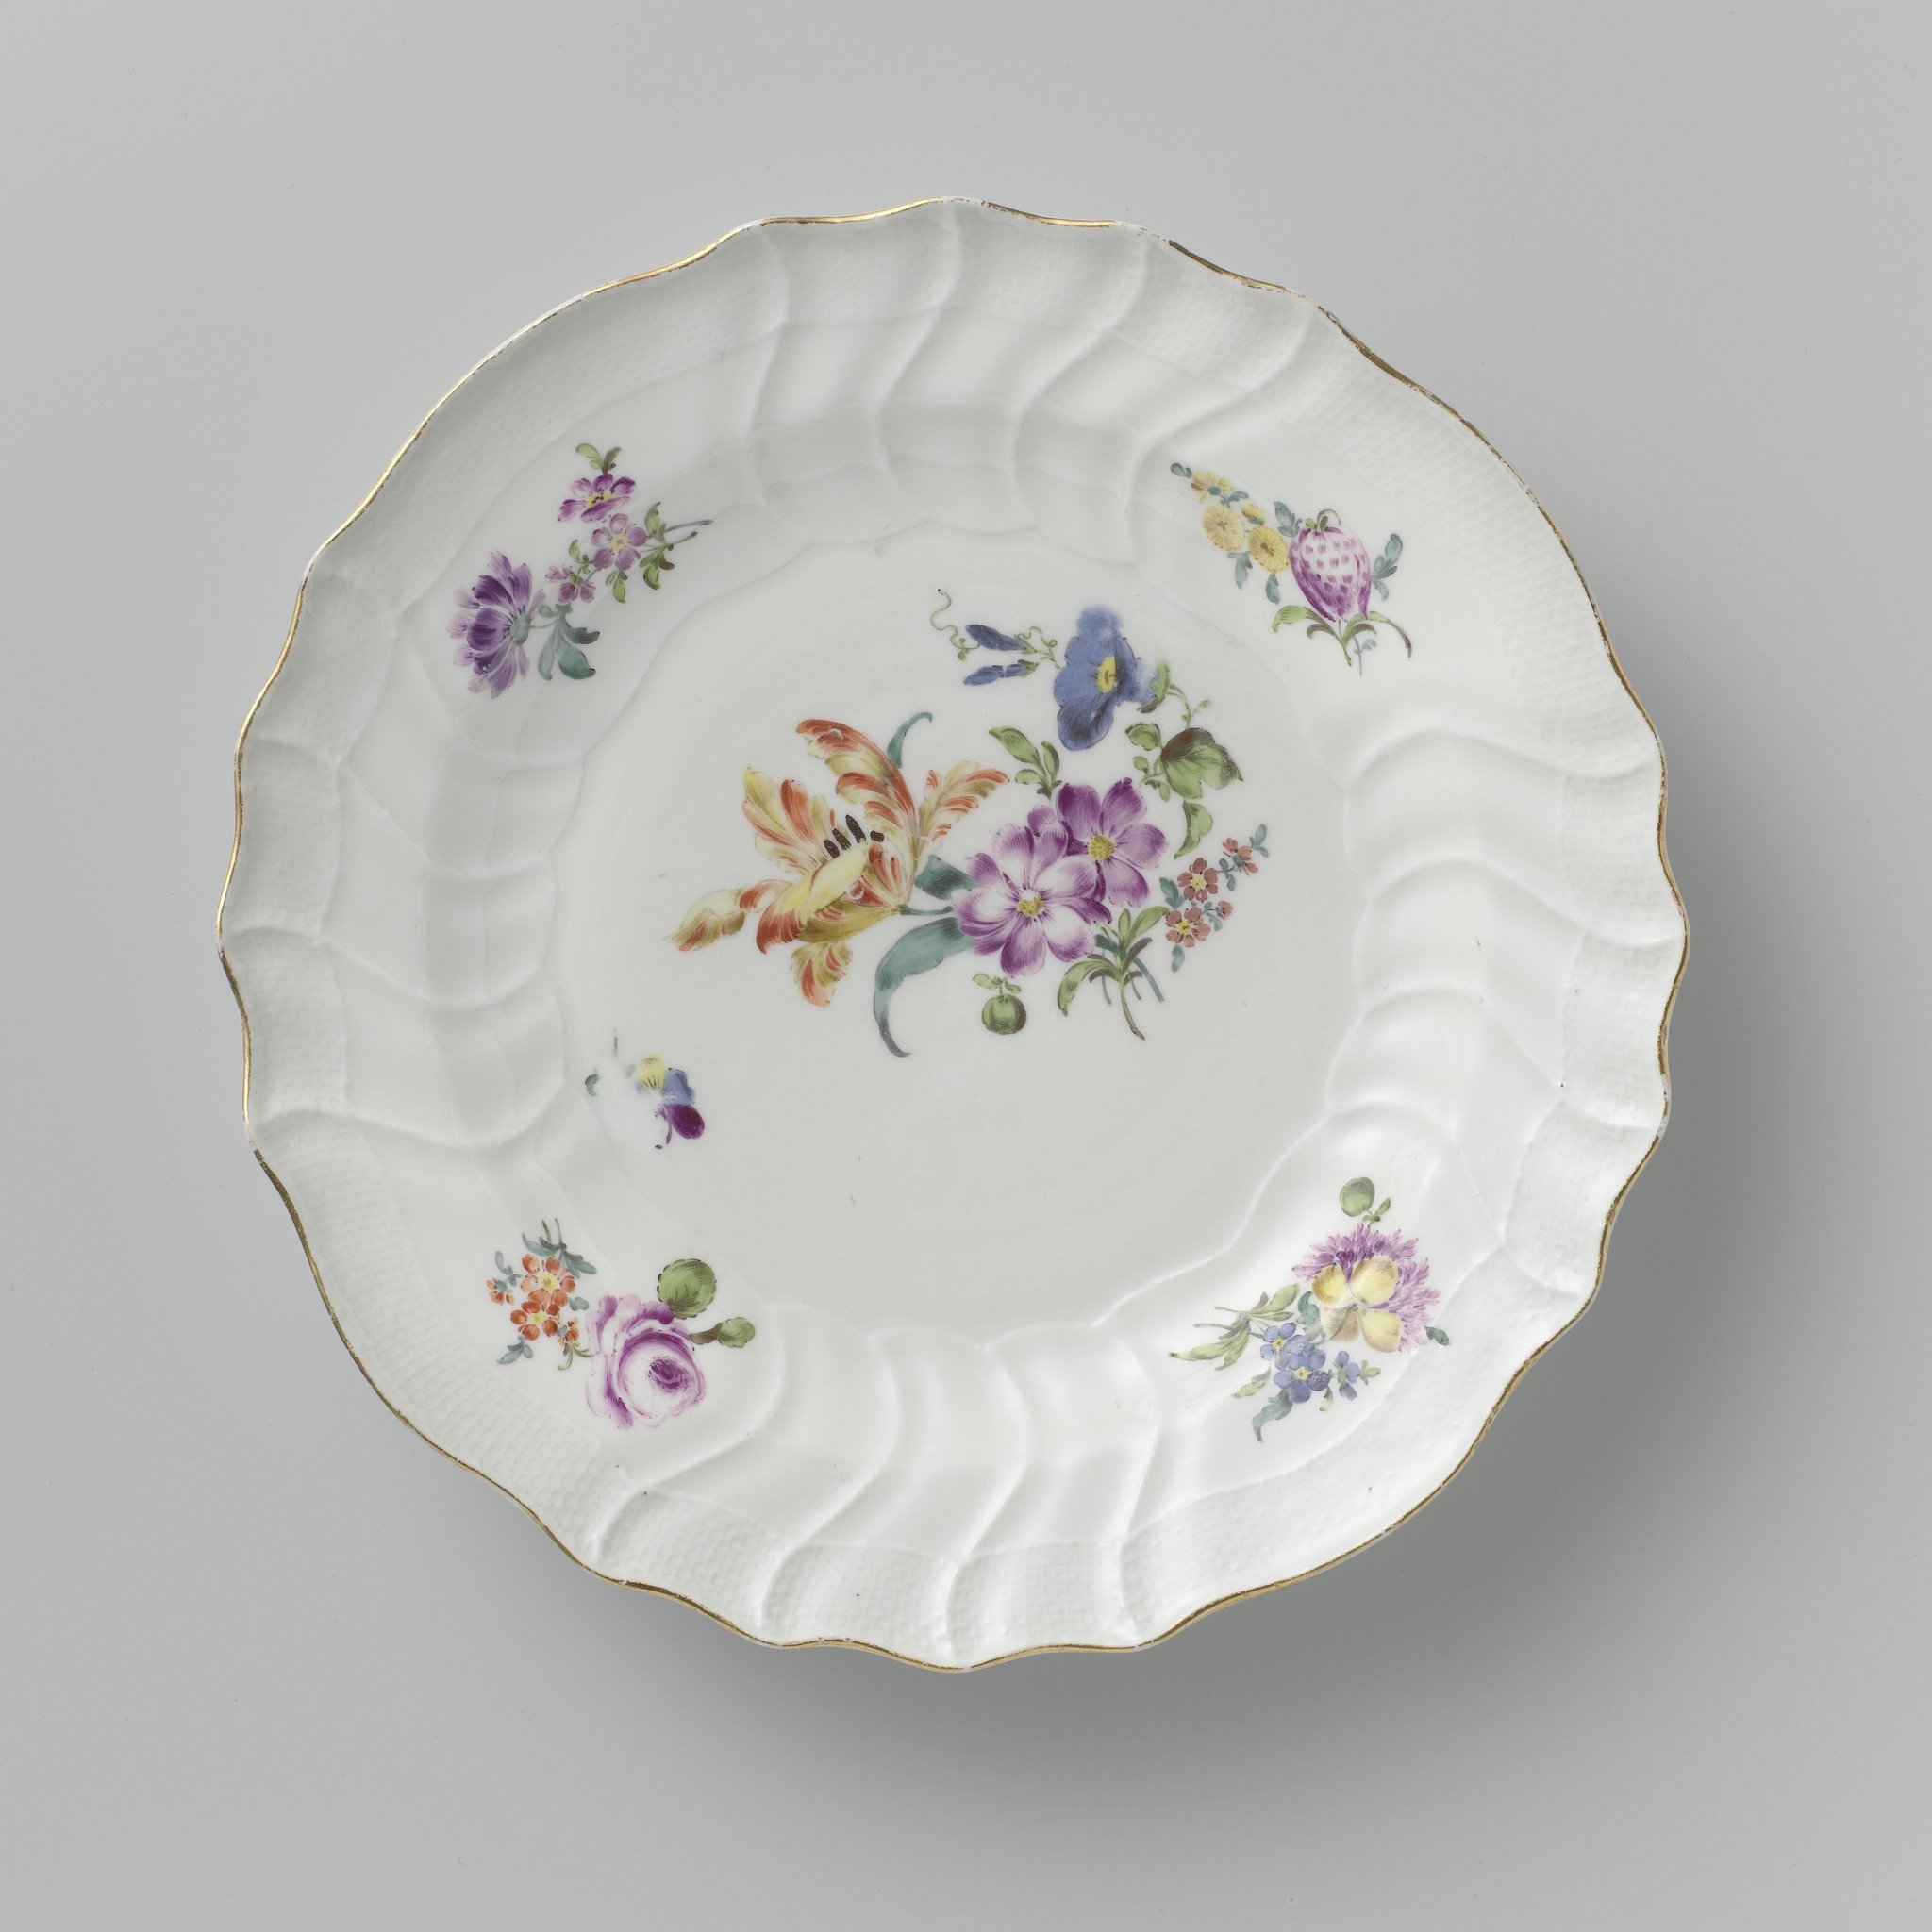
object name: plate dish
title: Bord, veelkleurig beschilderd met Deutsche Blumen, insekten en vruchten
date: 1750-1760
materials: porcelain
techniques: painted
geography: meissen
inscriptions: factory mark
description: Rond bord van beschilderd porselein. Het bord is beschilderd met Deutsche Blumen, insekten en vruchten. De rand is in reliëf versierd met het Neuozier-patroon. Het bord is gemerkt en hoort bij een servies (BK-17474-1 t/m BK-17474-253).